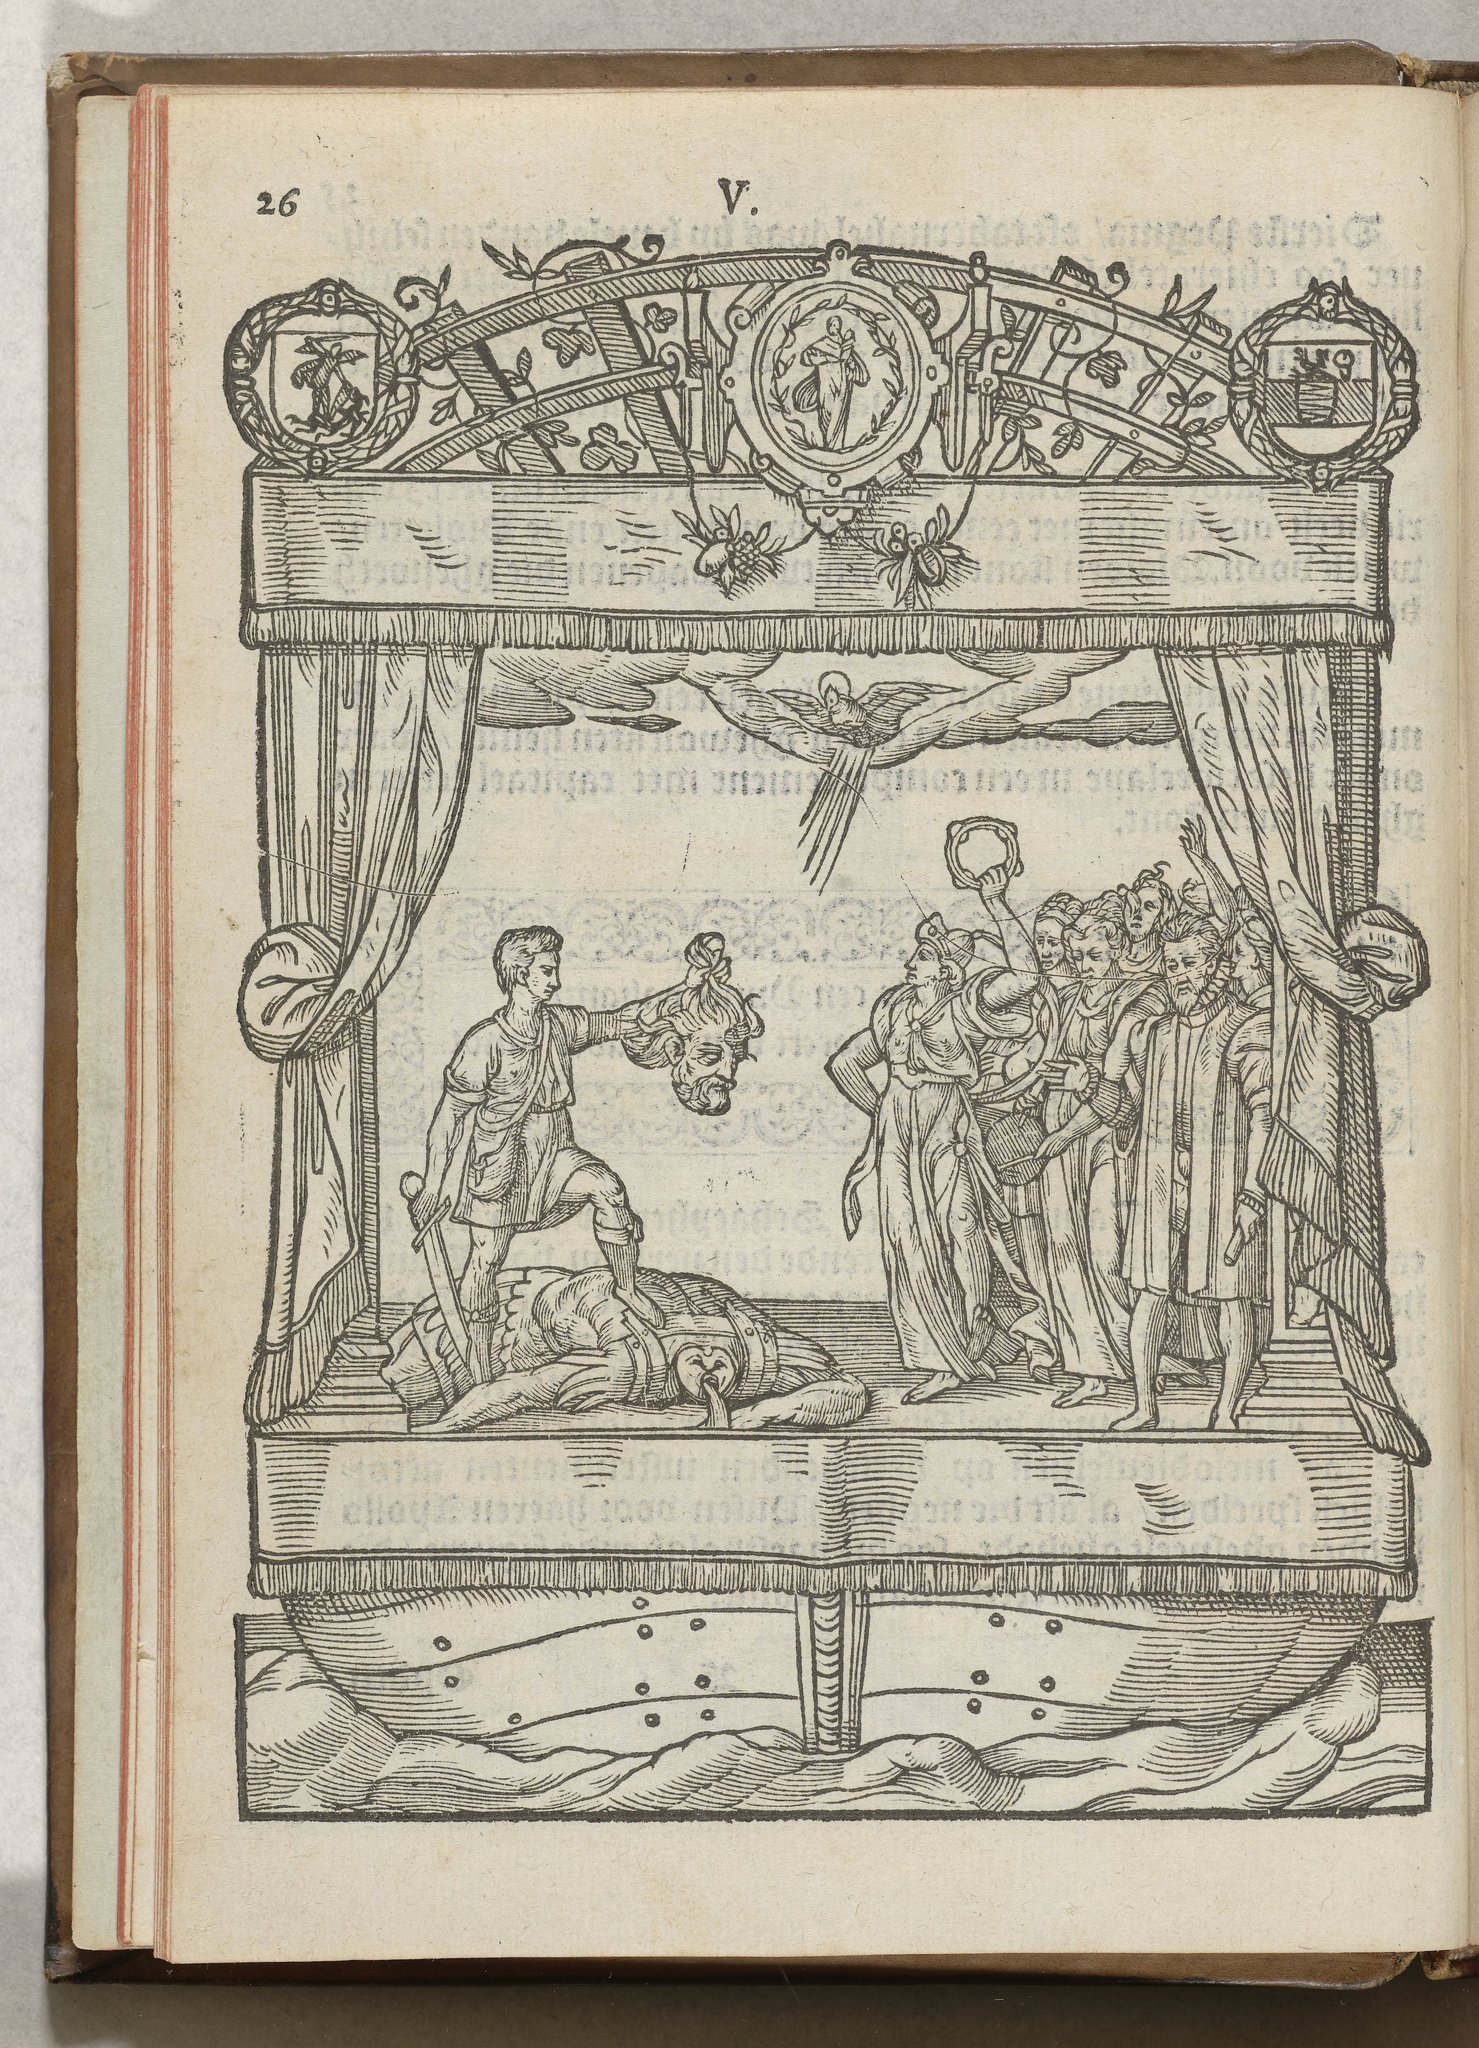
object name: print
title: De voorstelling van Het Mariacransken: David met het hoofd van Goliath, 1577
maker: antoni van leest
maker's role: print maker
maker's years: 1545-1592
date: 1577-1578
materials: paper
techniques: woodcut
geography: netherlands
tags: delft, william i (prince of orange), group of actors, troupe; actors on the stage, triumphal entry and public reception, pageant, 'entrée solennelle', 'joyeuse entrée', david's triumph: the women of israel come out to welcome david, singing, dancing, and playing tambourines and lyres; david holding the head of goliath, brussels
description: Illustratie in: J. B. Houwaert, Declaratie van die triumphante incompst vande doorluchtighen ende hoogheboren Prine van Oraingnien, binnen die princelijcke stadt van Brussele, geschiet in t' iaer ... 1578, den 18 Septembris, Christoffel Plantijn, Antwerpen 1579. Boek in de bibliotheek met signatuur: 325 D 29.